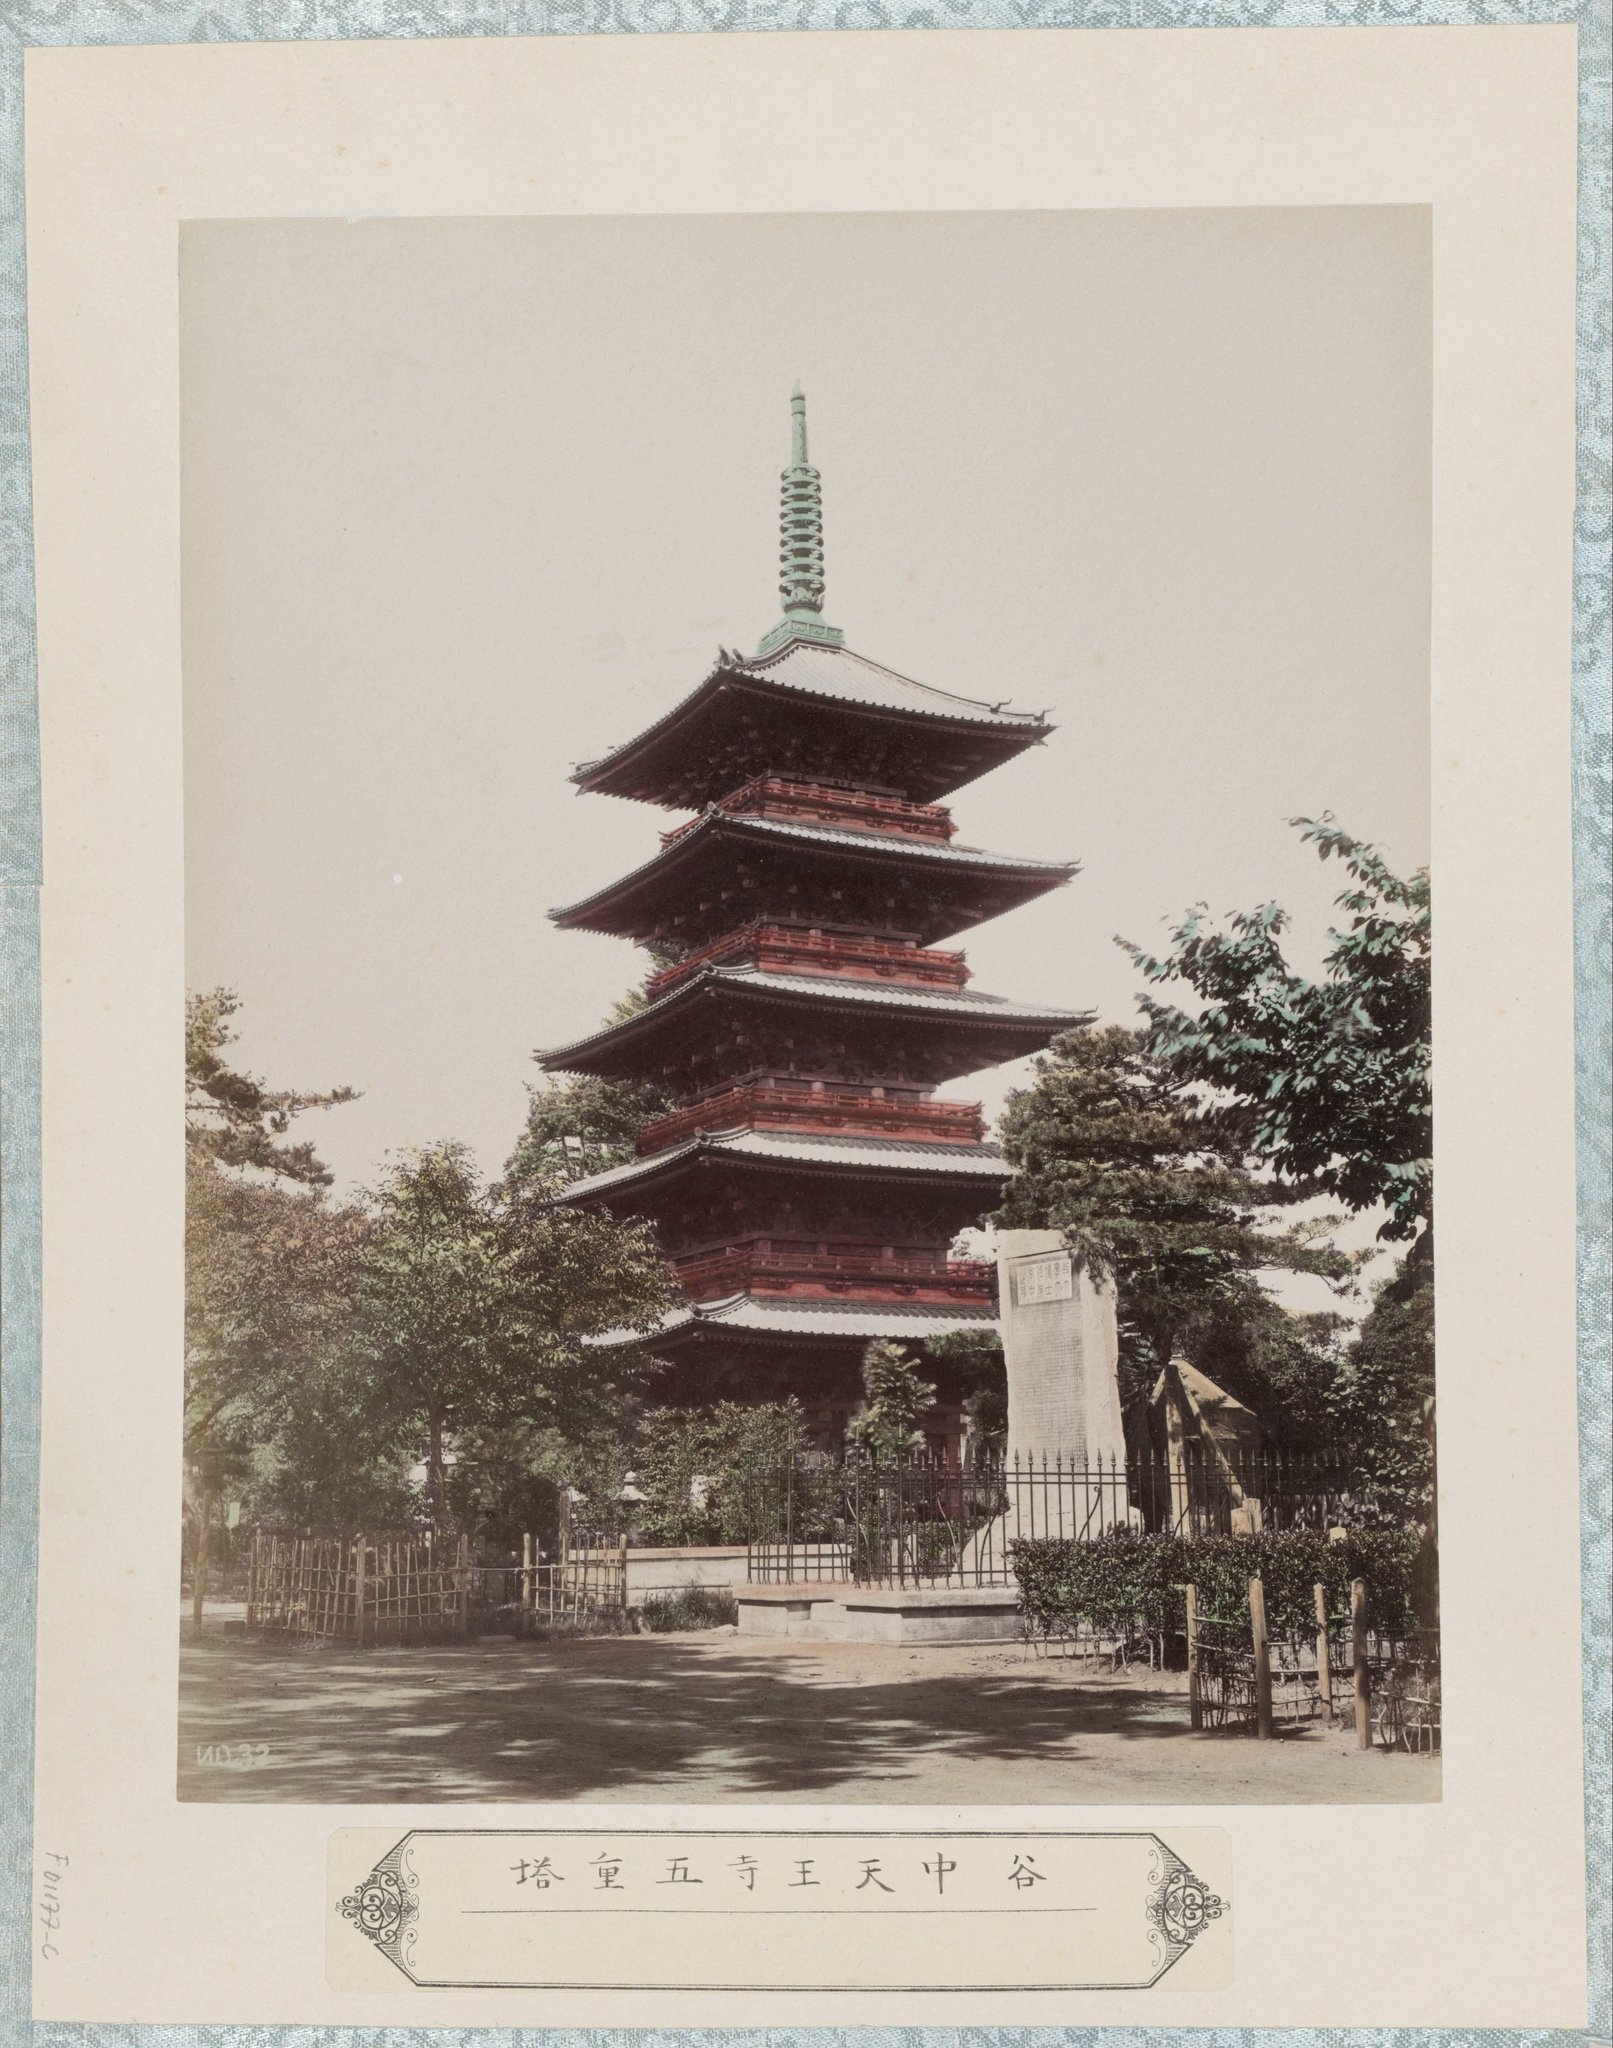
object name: photograph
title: Yanaka Tennôji gojûnotô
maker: Anonymous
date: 1870-1900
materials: cardboard, paper, photographic support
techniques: albumen print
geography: tokyo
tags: temple, shrine ~ hinduism, buddhism, jainism, trees, fence, wall, paling, travelling; tourism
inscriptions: negative number: ‘32’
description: Onderdeel van Leporelloalbum met 30 foto's van bezienswaardigheden in Japan.